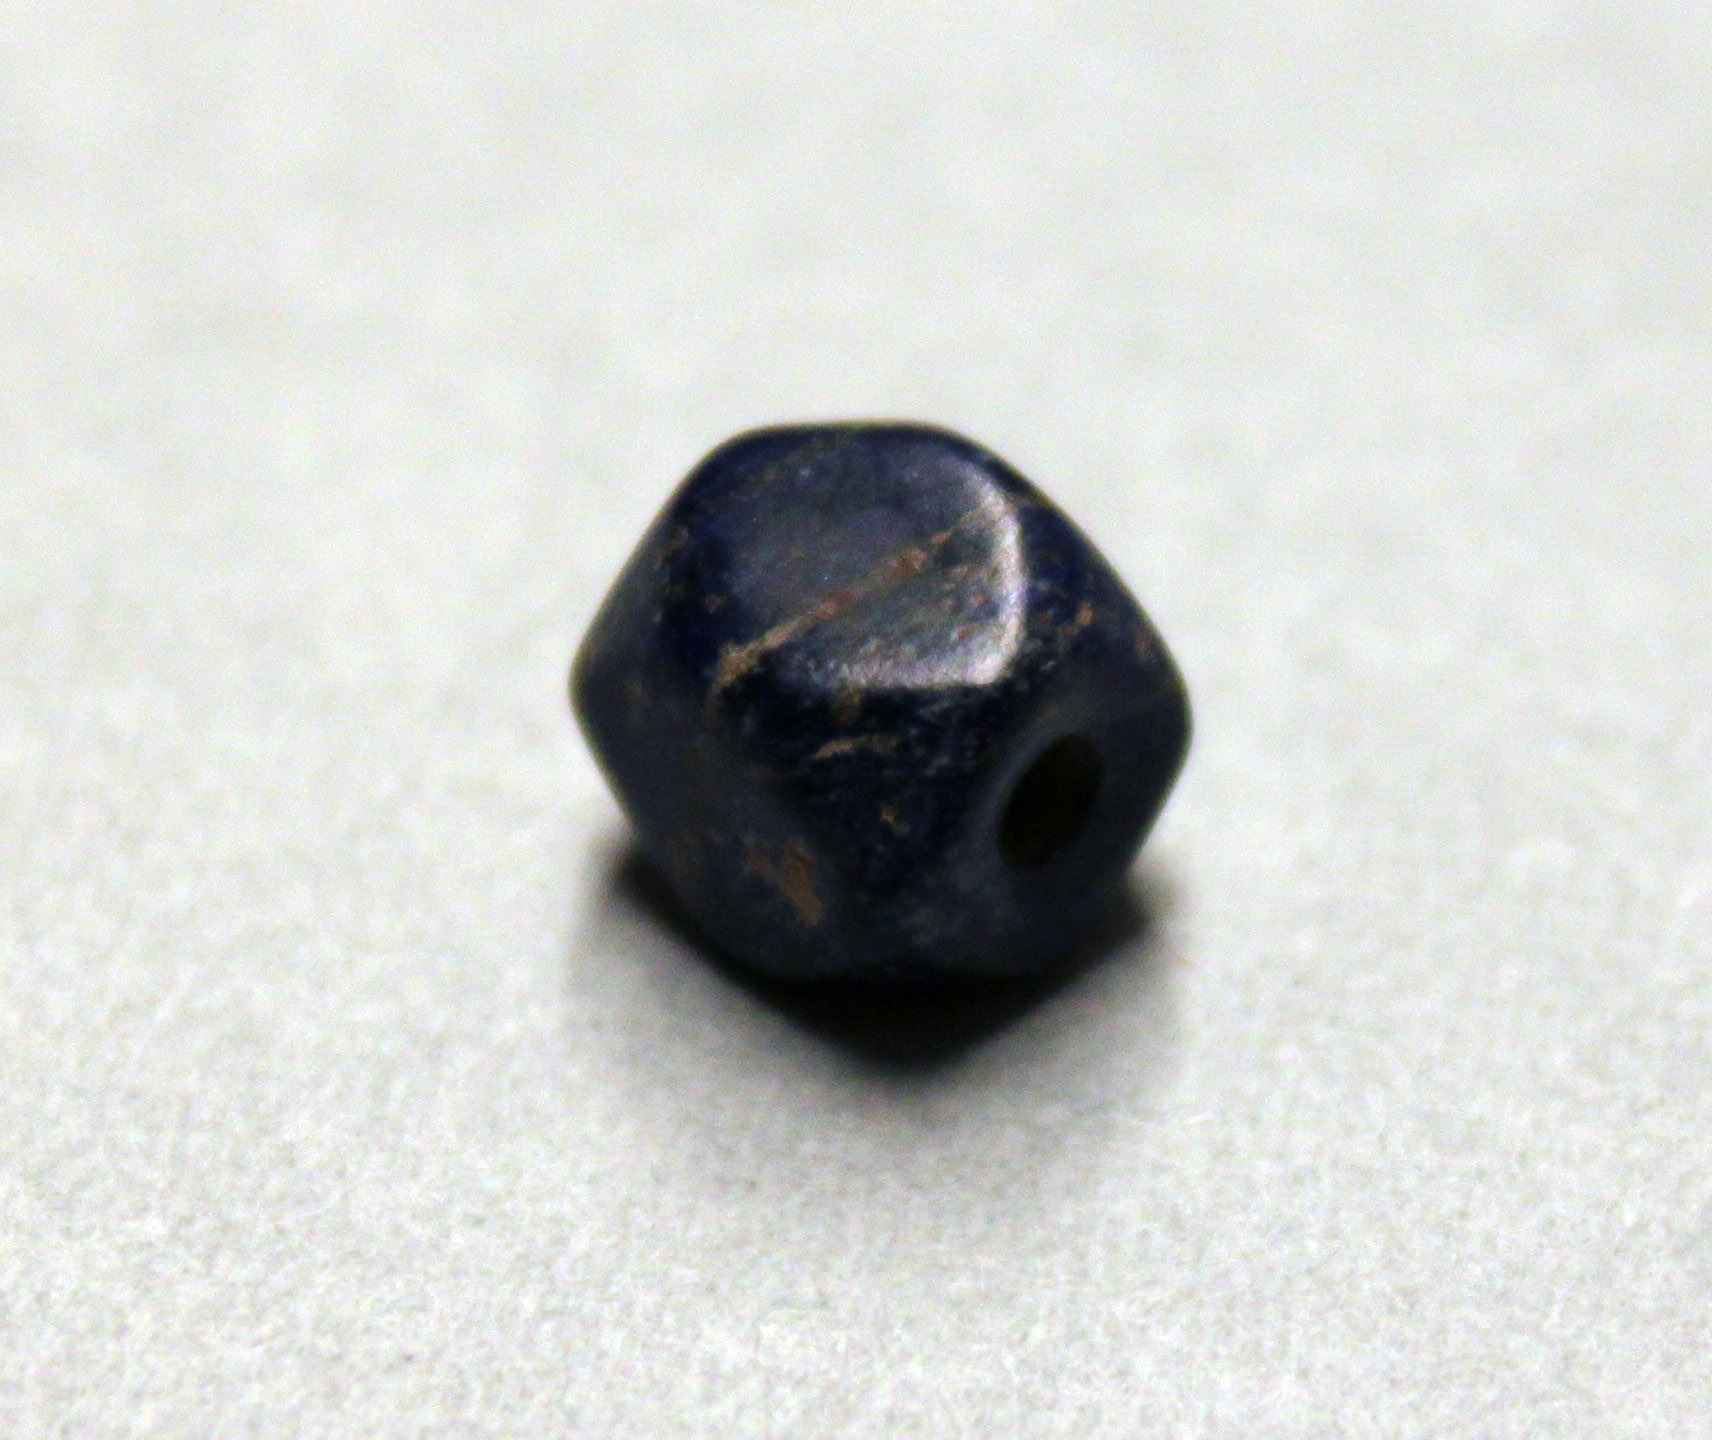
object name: bead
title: Beads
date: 801-1200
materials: lapis lazuli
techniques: cutting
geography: iran